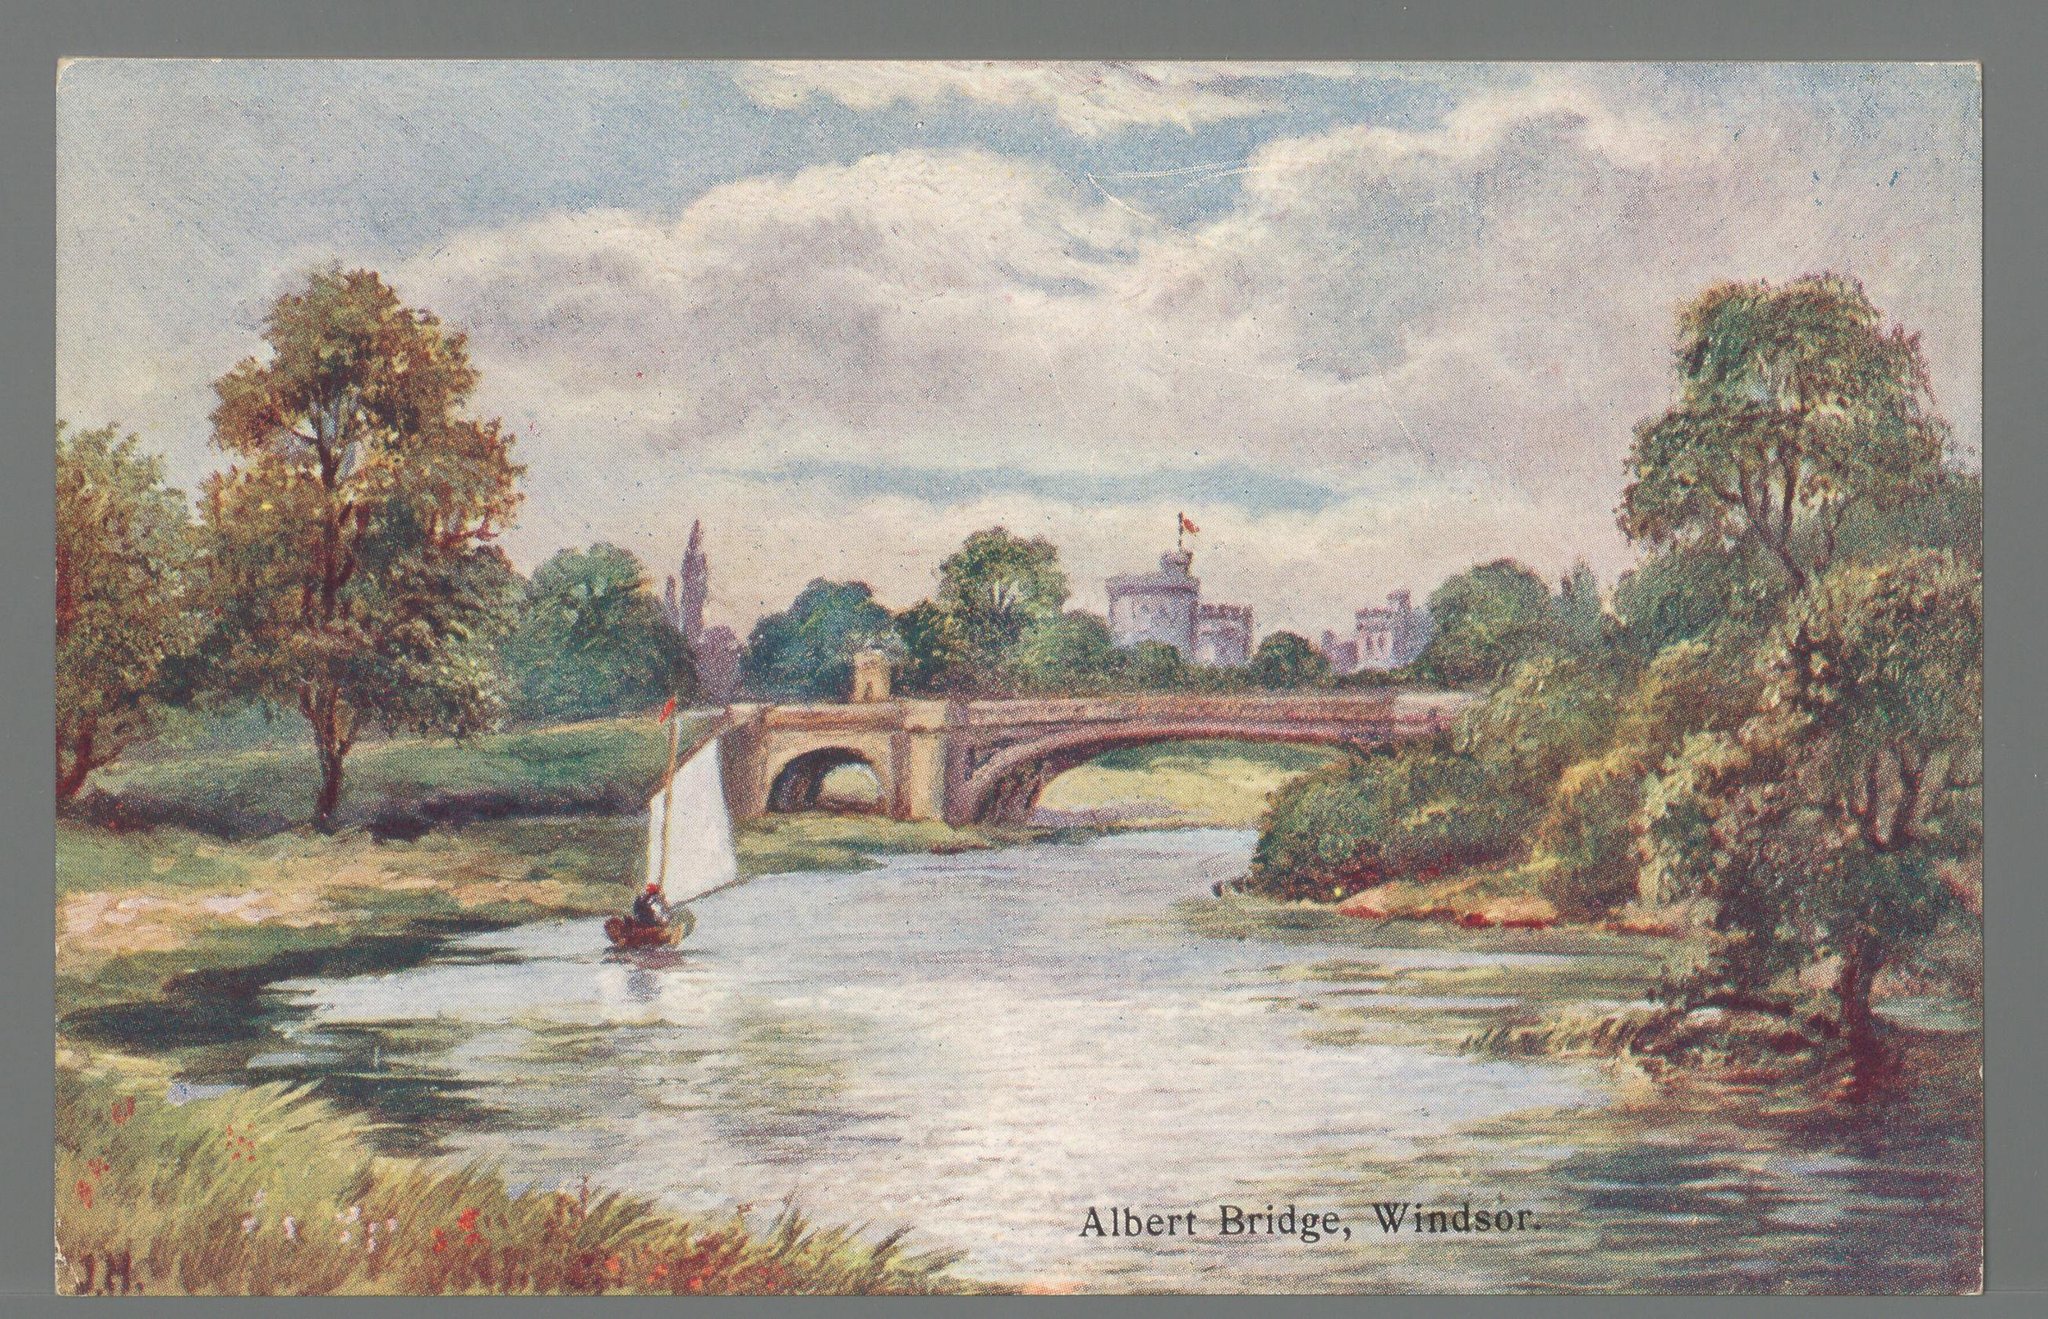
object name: ansichtkaart, prentbriefkaart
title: Albert Bridge, Windsor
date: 1902-1940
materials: cardboard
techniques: color autotype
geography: london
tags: castle, canals, waters (in city), bridge in city across river, canal, etc., thames